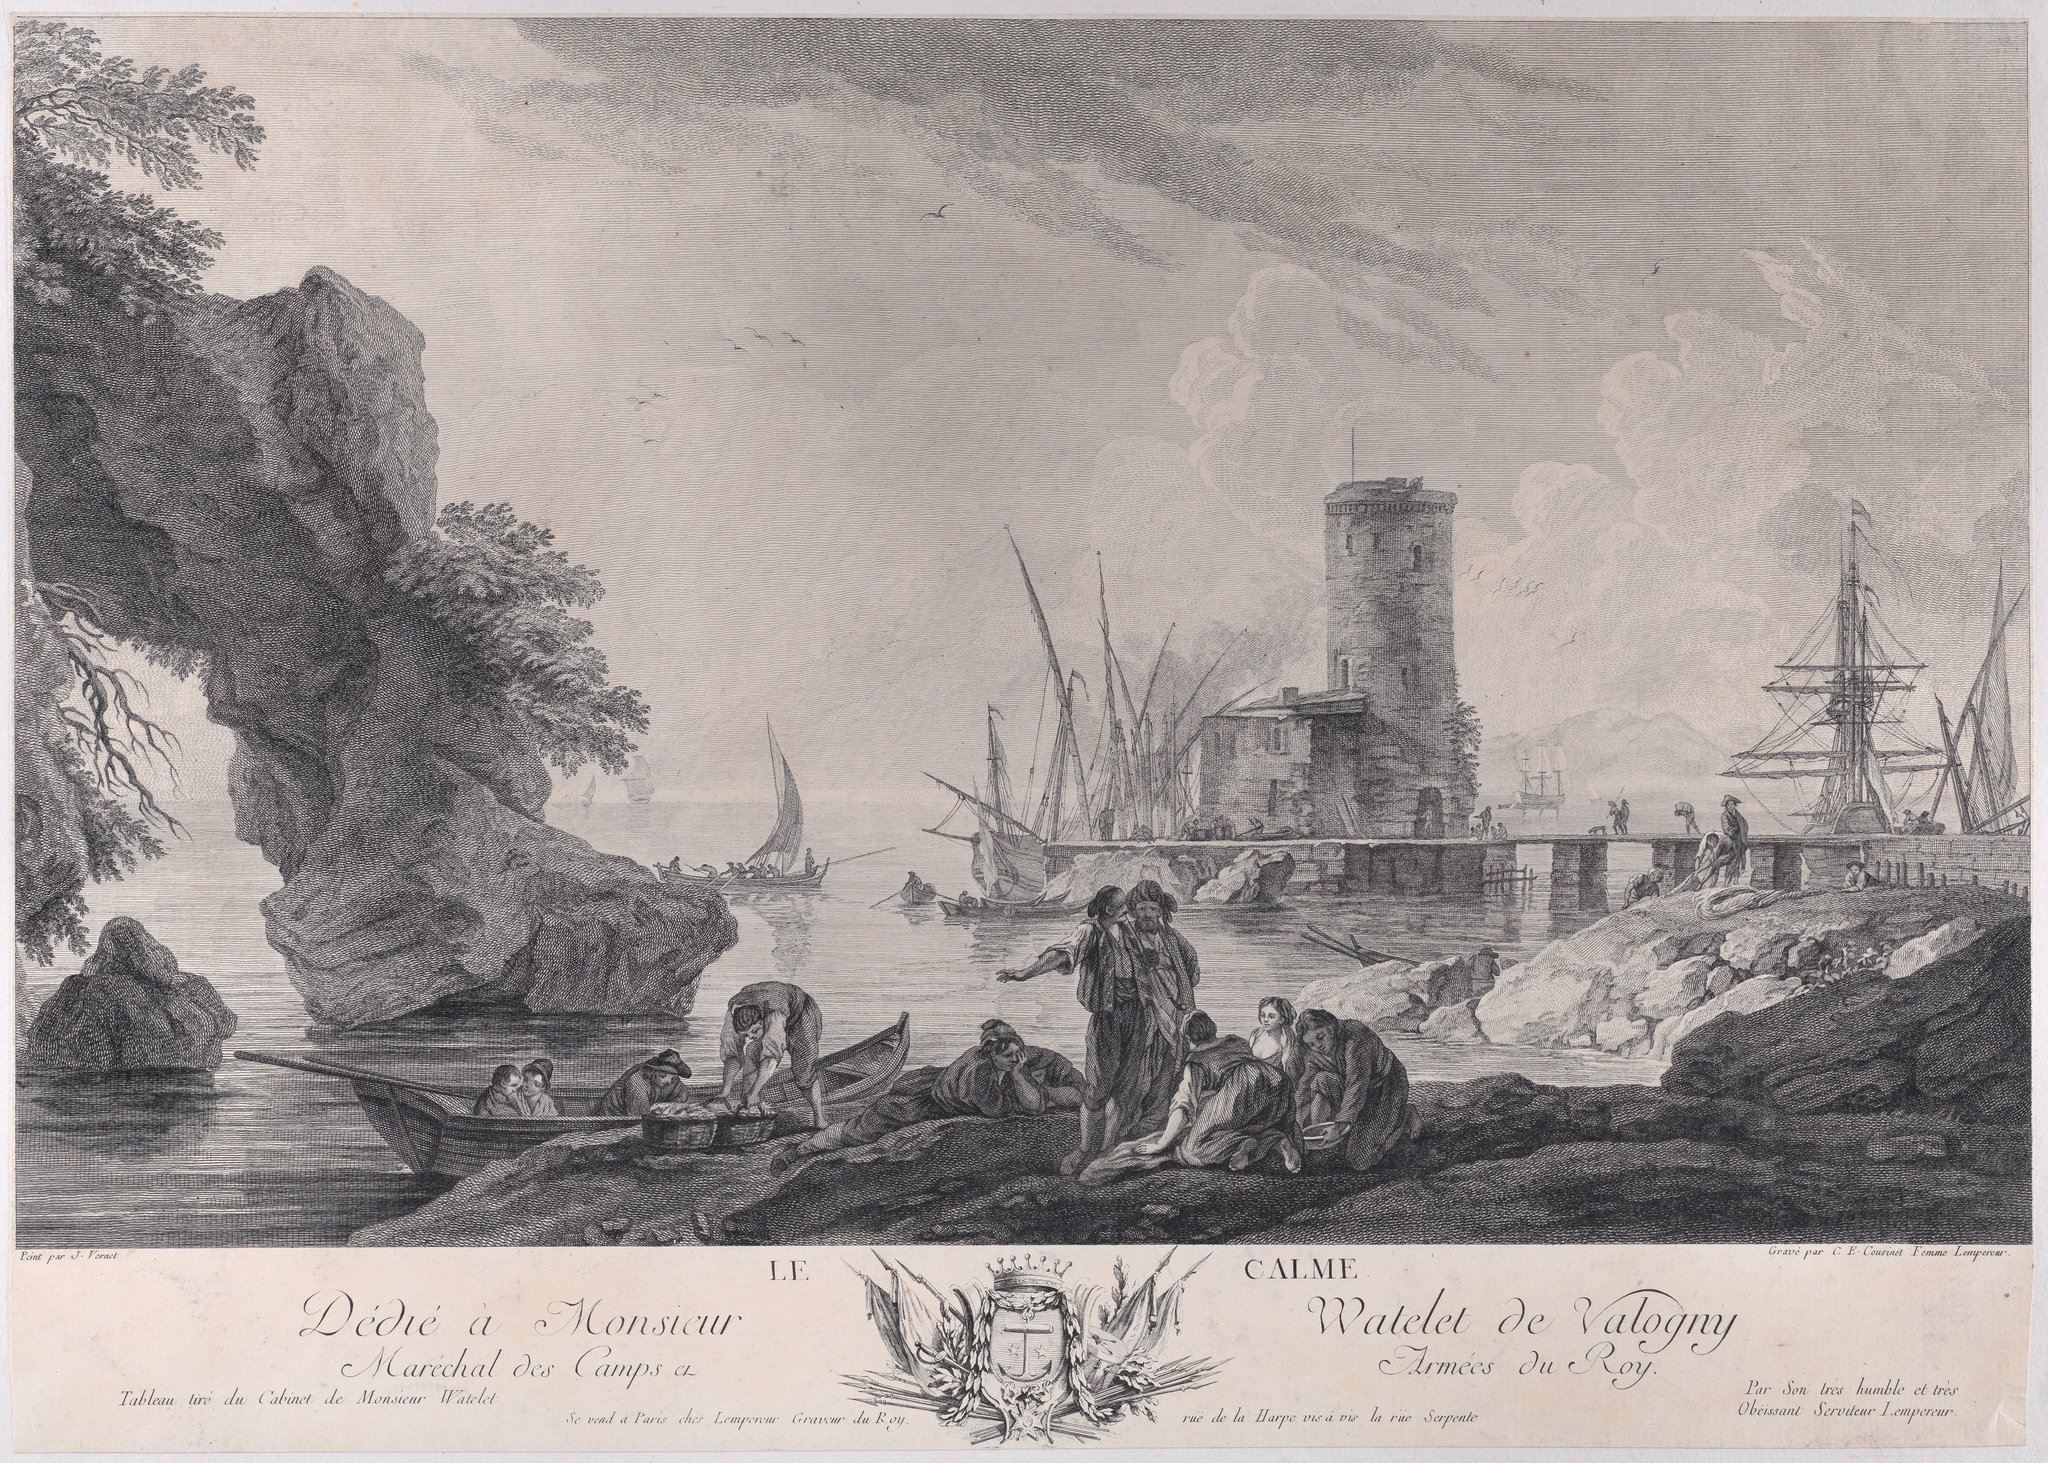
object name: print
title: The Calm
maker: joseph vernet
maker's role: artist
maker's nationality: french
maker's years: 1714-1789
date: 1750-1790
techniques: engraving